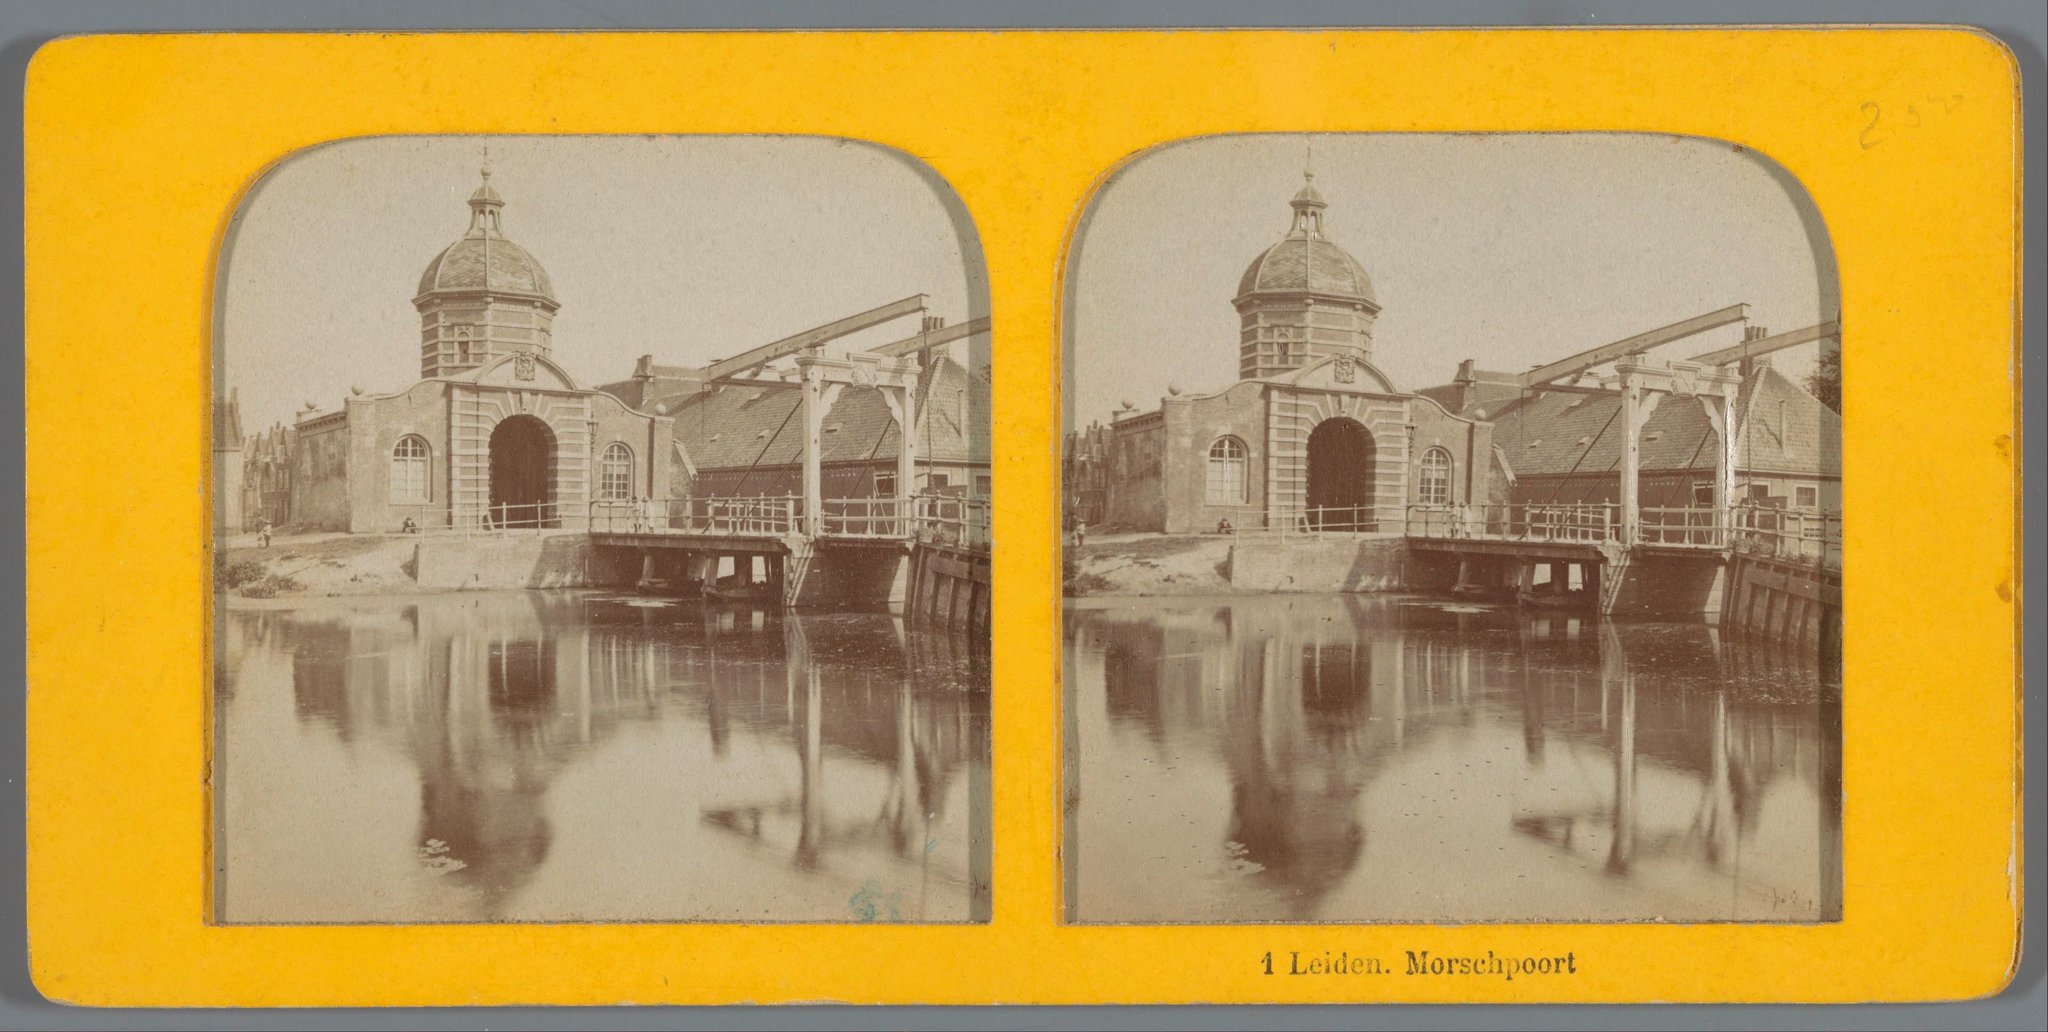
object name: tissue stereograph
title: Leiden. Morschpoort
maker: Anonymous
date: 1855-1875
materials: cardboard, paper, photographic support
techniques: albumen print, cutting, hand coloring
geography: leiden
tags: bridge in city across river, canal, etc. - ii - ideal city, city-gate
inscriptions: number: ‘9’, number: ‘1’